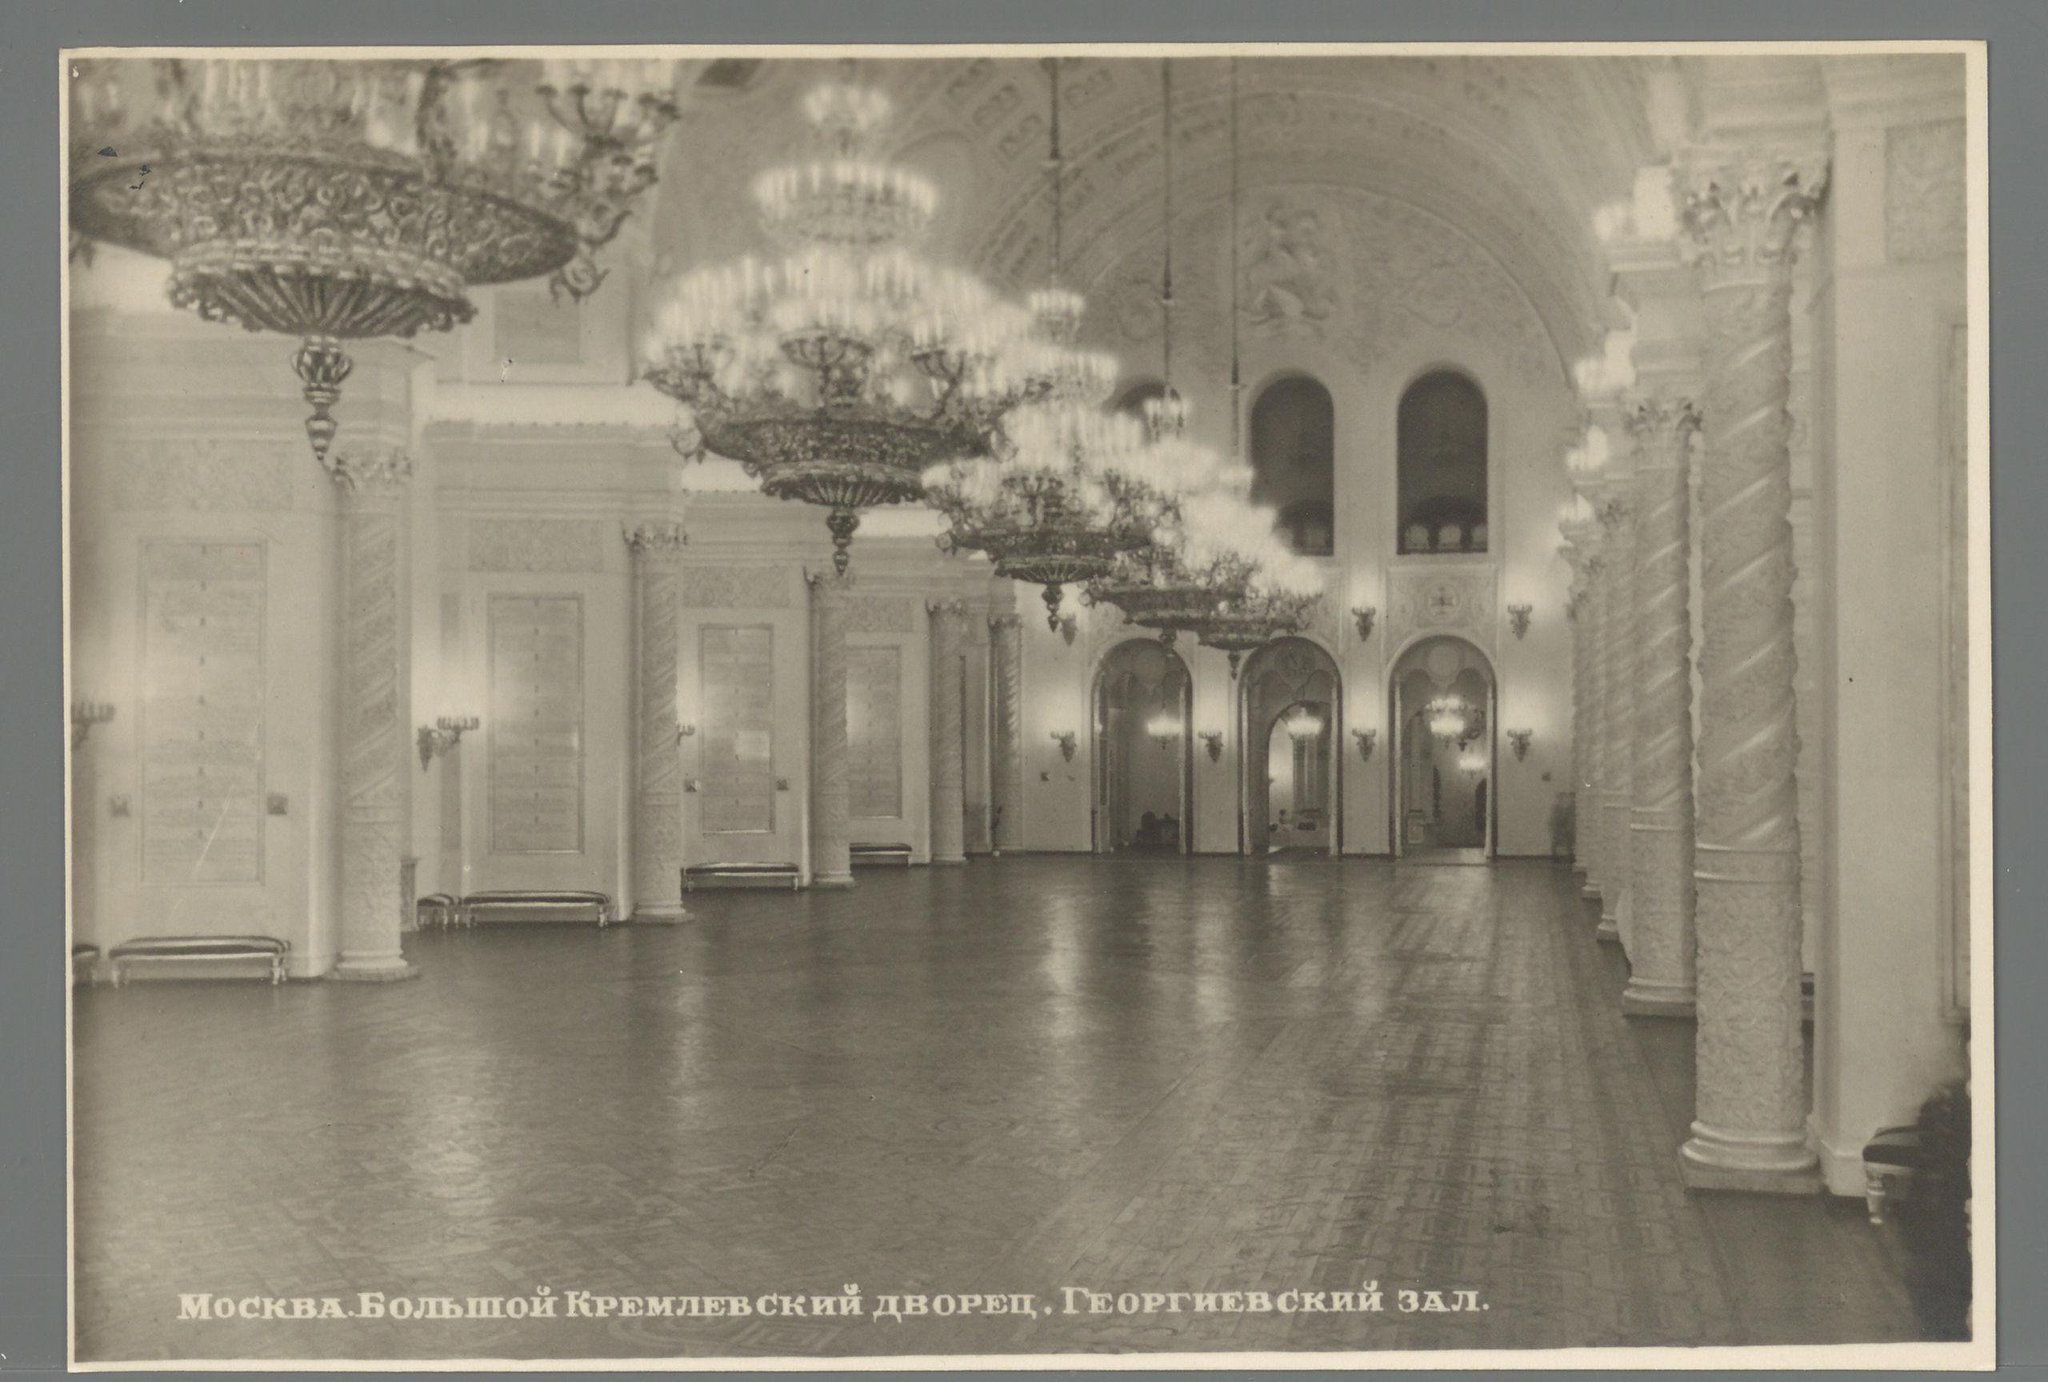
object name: ansichtkaart, prentbriefkaart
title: St. George Hall in het Groot Paleis in het Kremlin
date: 1954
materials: paper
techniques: gelatin silver print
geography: moscow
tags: palace, vestibule, hall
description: De titel op object staat in het Russisch.